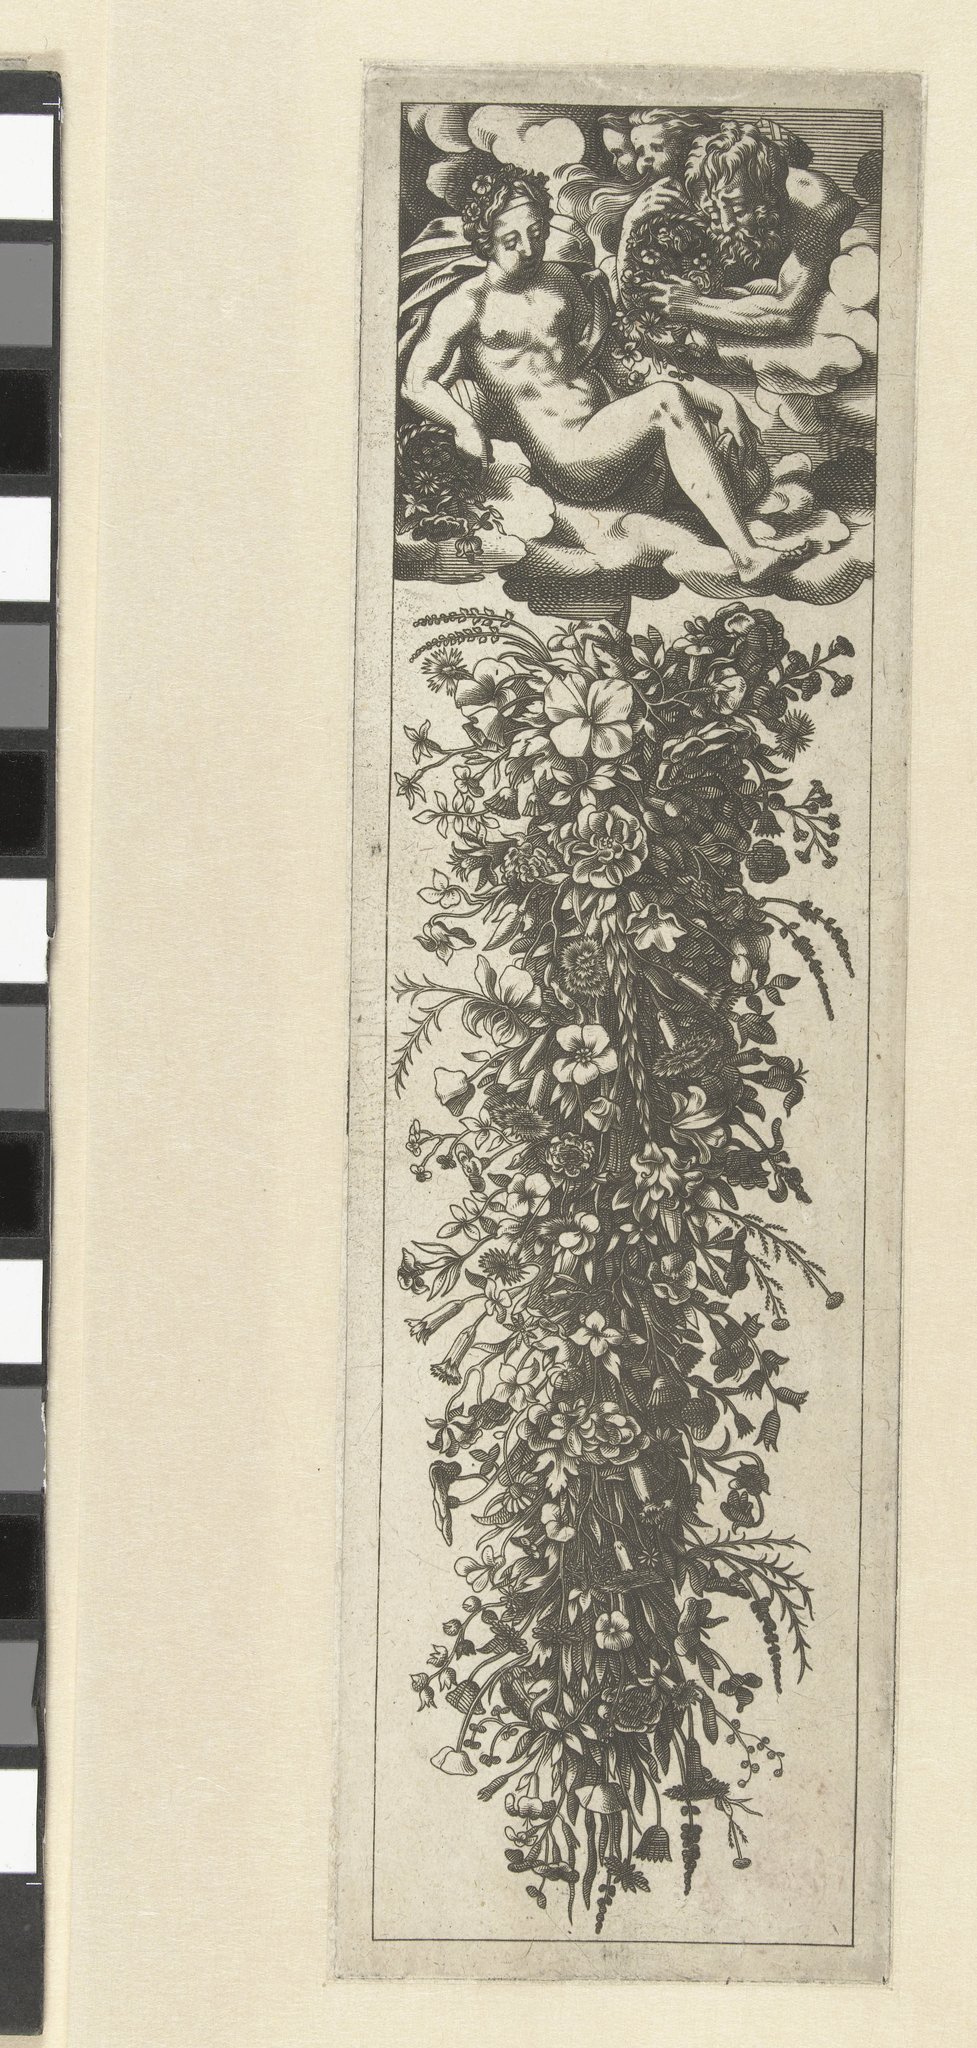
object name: print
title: Festoen van bloemen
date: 1551-1580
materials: paper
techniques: engraving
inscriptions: collector's mark: Lugt 240